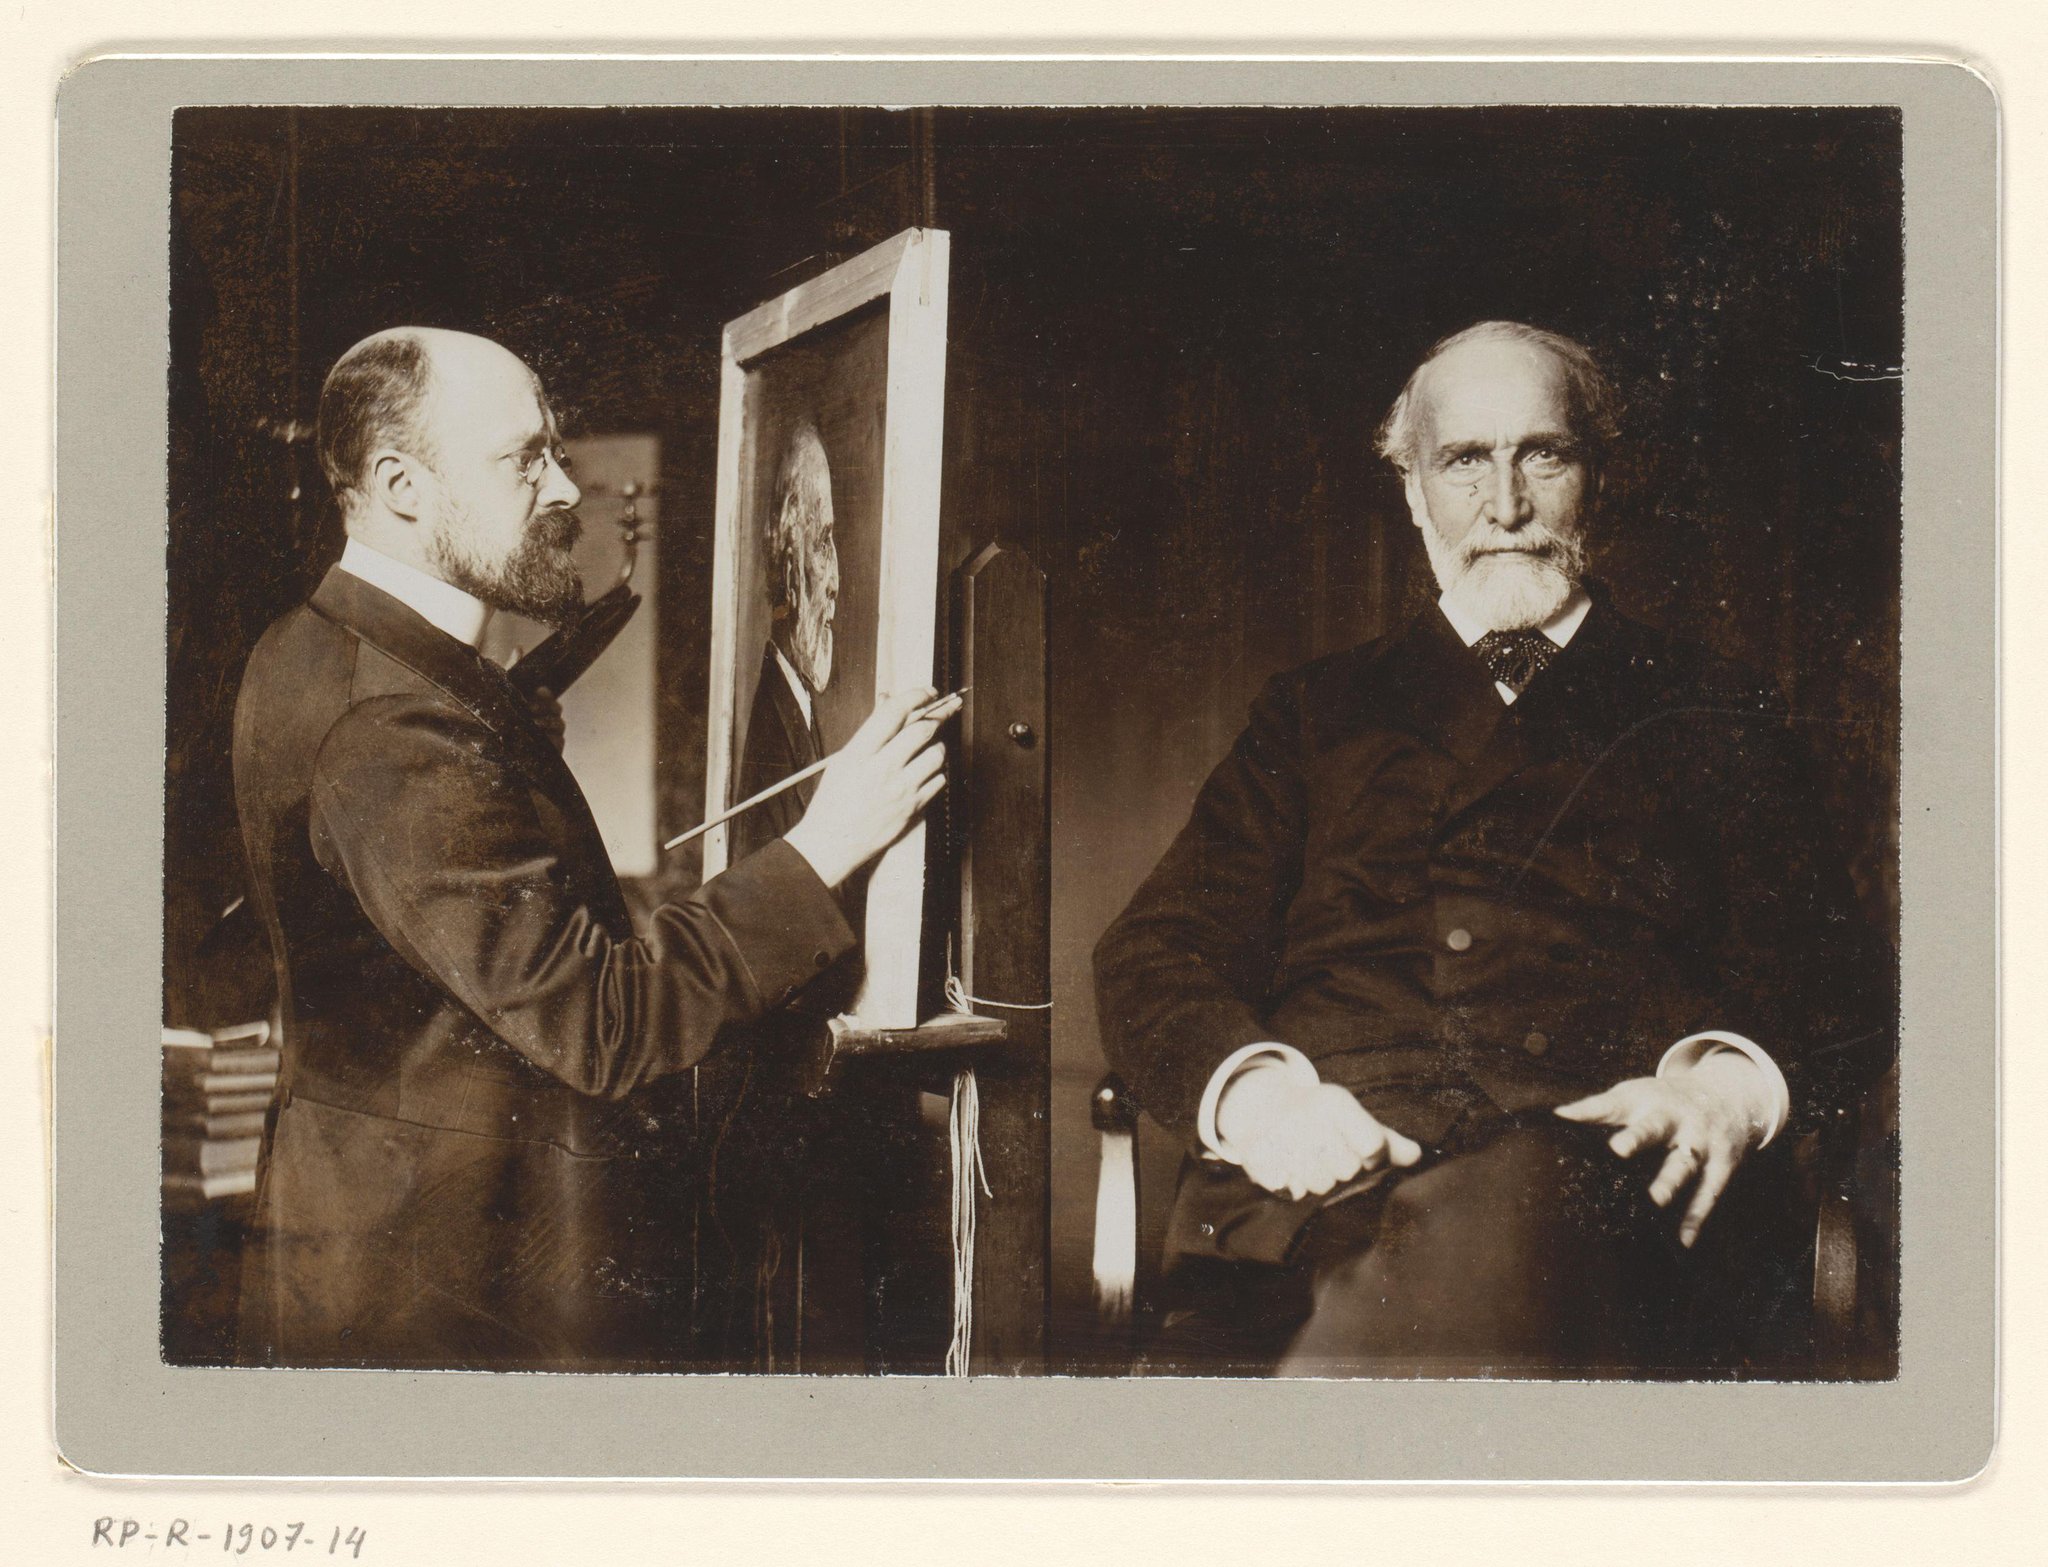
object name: photograph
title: Jan Veth schildert een portret van Willem Stoeder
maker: pieter van der wielen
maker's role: apotheker, professor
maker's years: 1872-1947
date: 1901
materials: paper, cardboard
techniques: collodion silver print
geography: amsterdam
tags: dordrecht, painter, print maker, draughtsman, designer, jan veth, model, sitter ~ painting, painter at work, in his studio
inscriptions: collector's mark: Lugt 2166, inscription: ‘Prof. W. Stoeder Dr. Jan Veth’